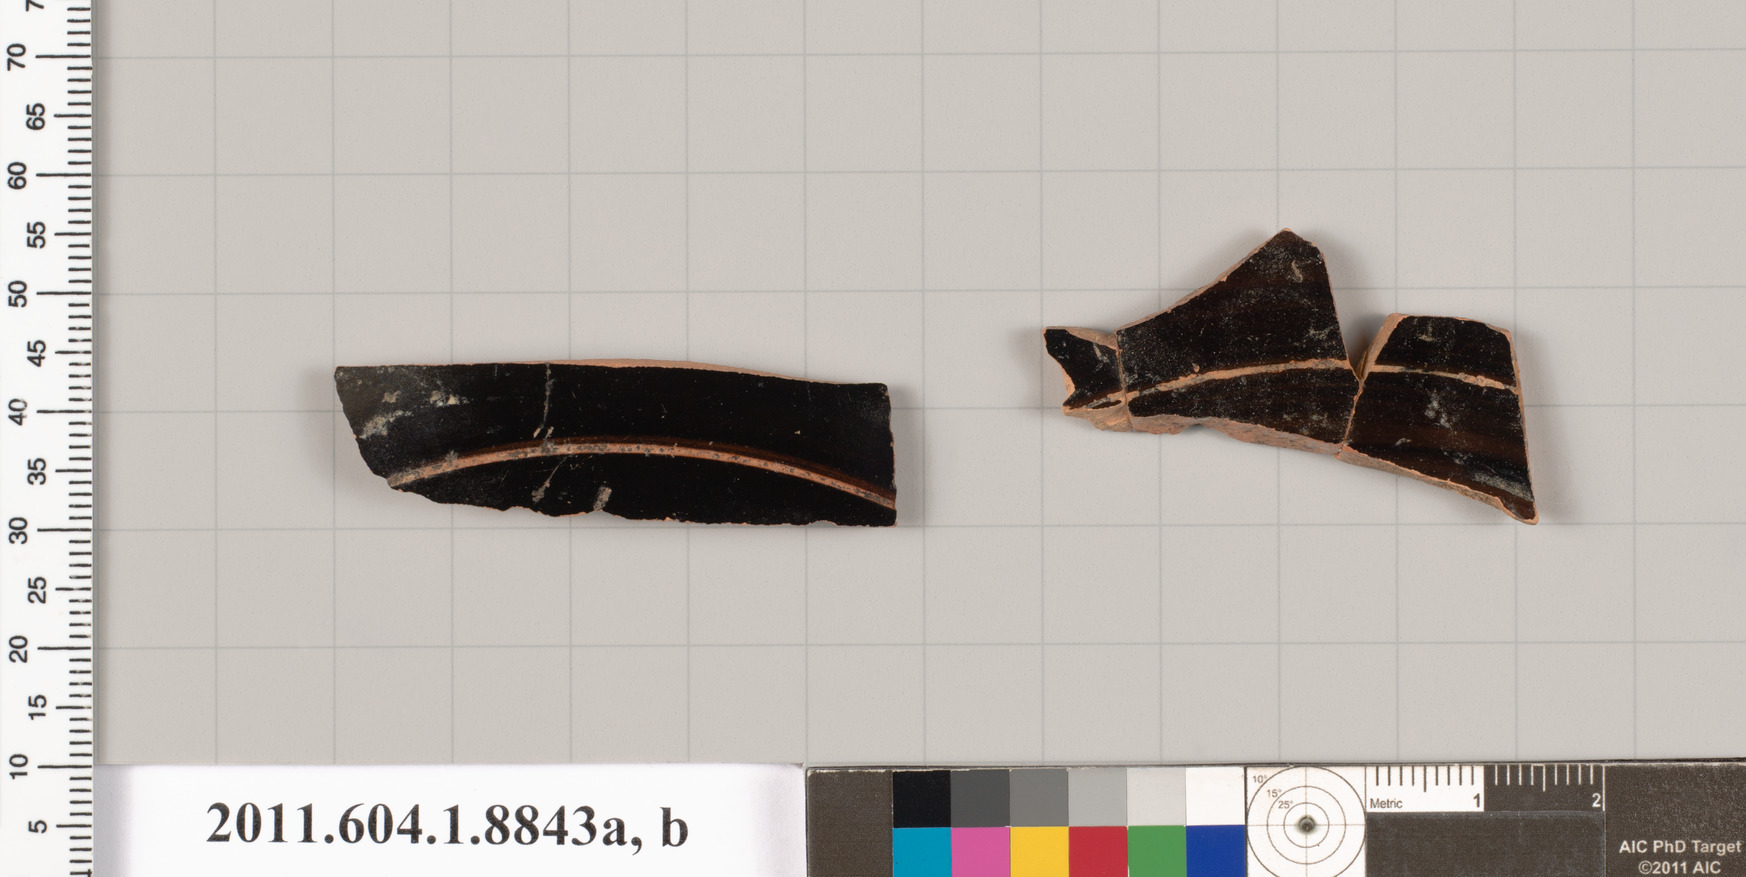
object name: kylix fragment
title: Terracotta fragments of kylikes (drinking cups)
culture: greek, attic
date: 500-470 BCE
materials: terracotta